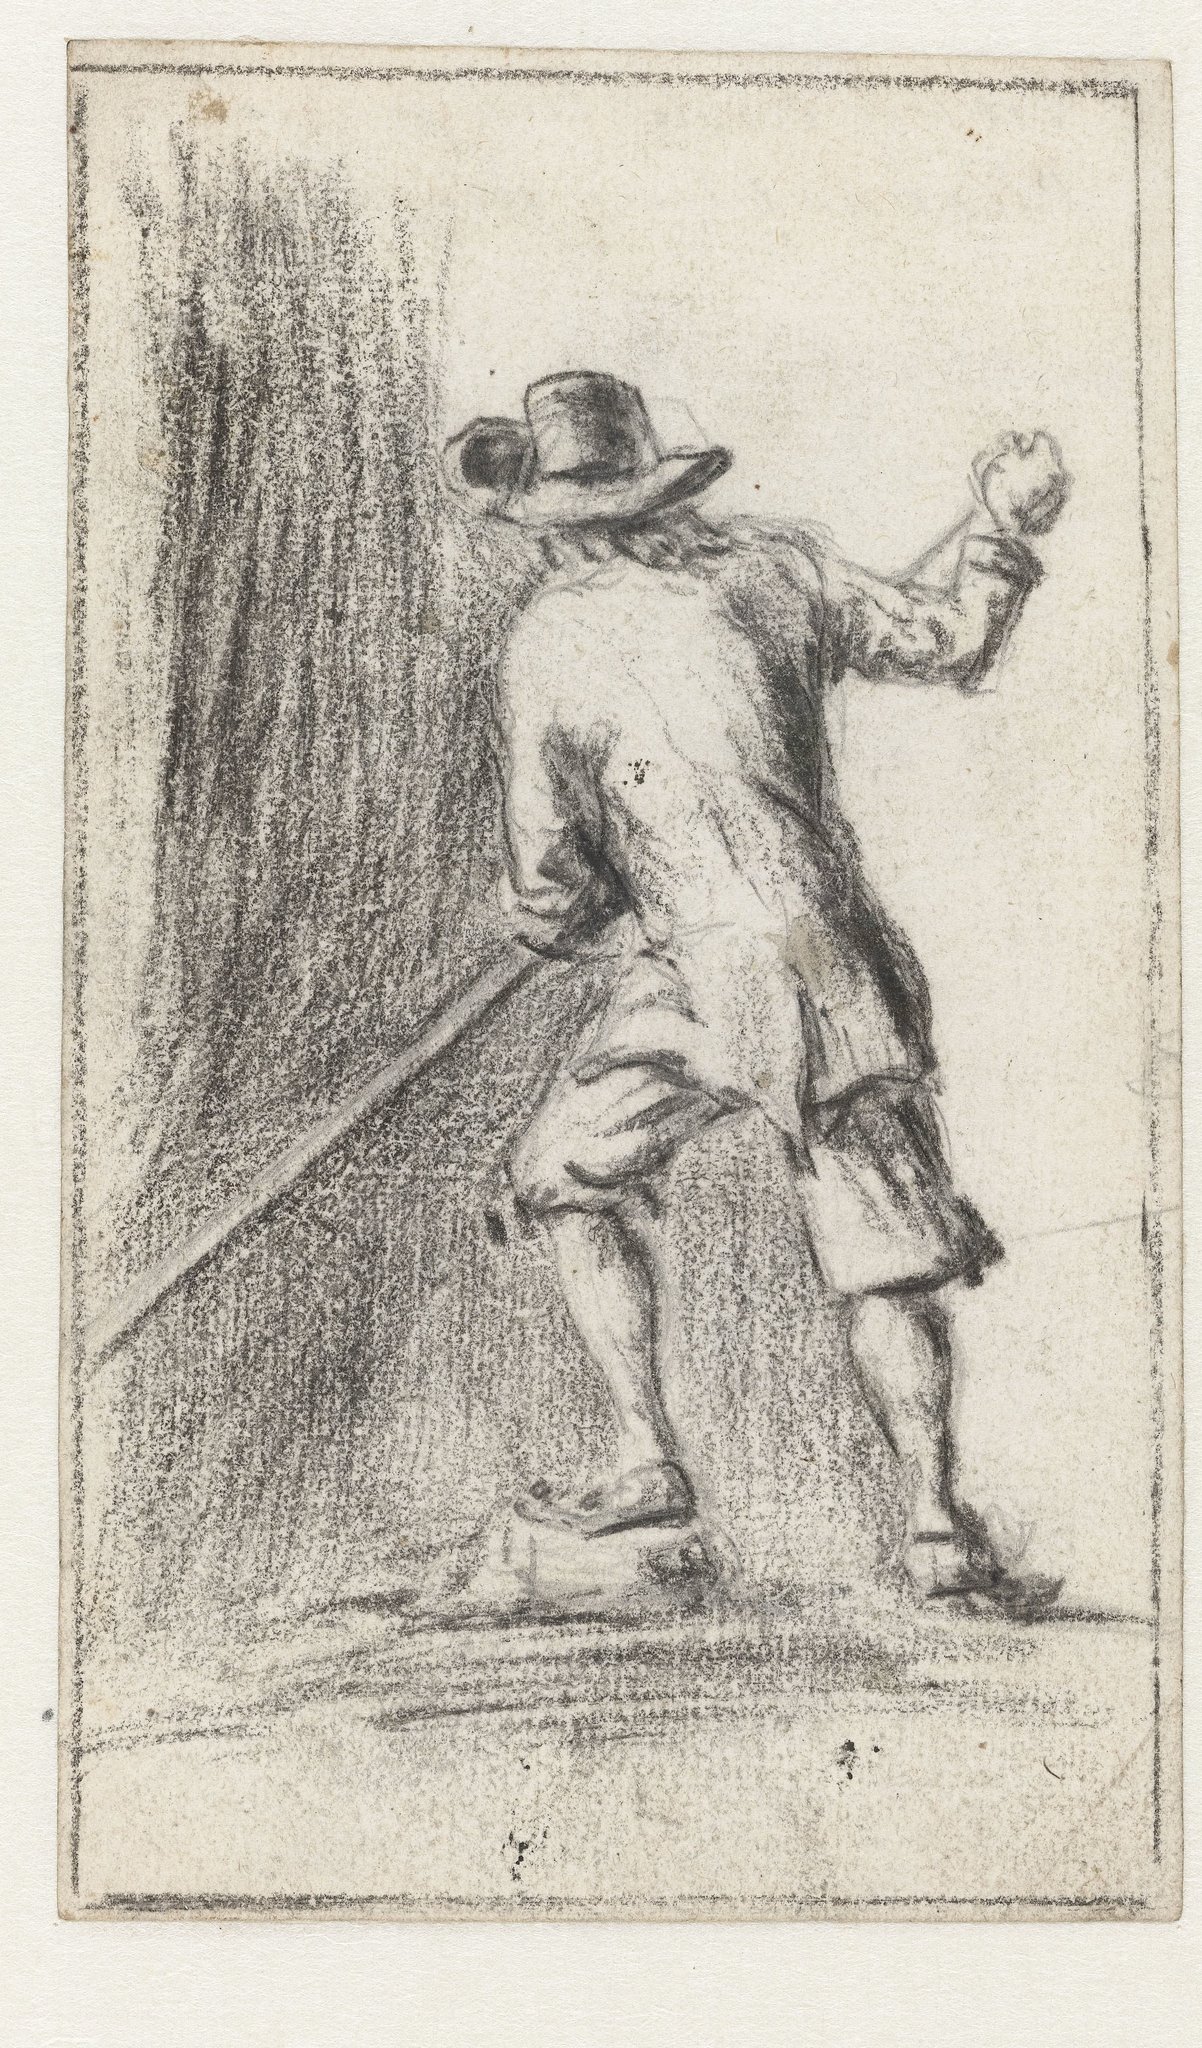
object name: drawing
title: Man met een vaarboom, op de rug gezien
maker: ludolf bakhuysen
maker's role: draughtsman, print maker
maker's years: 1631-1708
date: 1636-1651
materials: chalk, paper, pencil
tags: standing figure, poling, punting